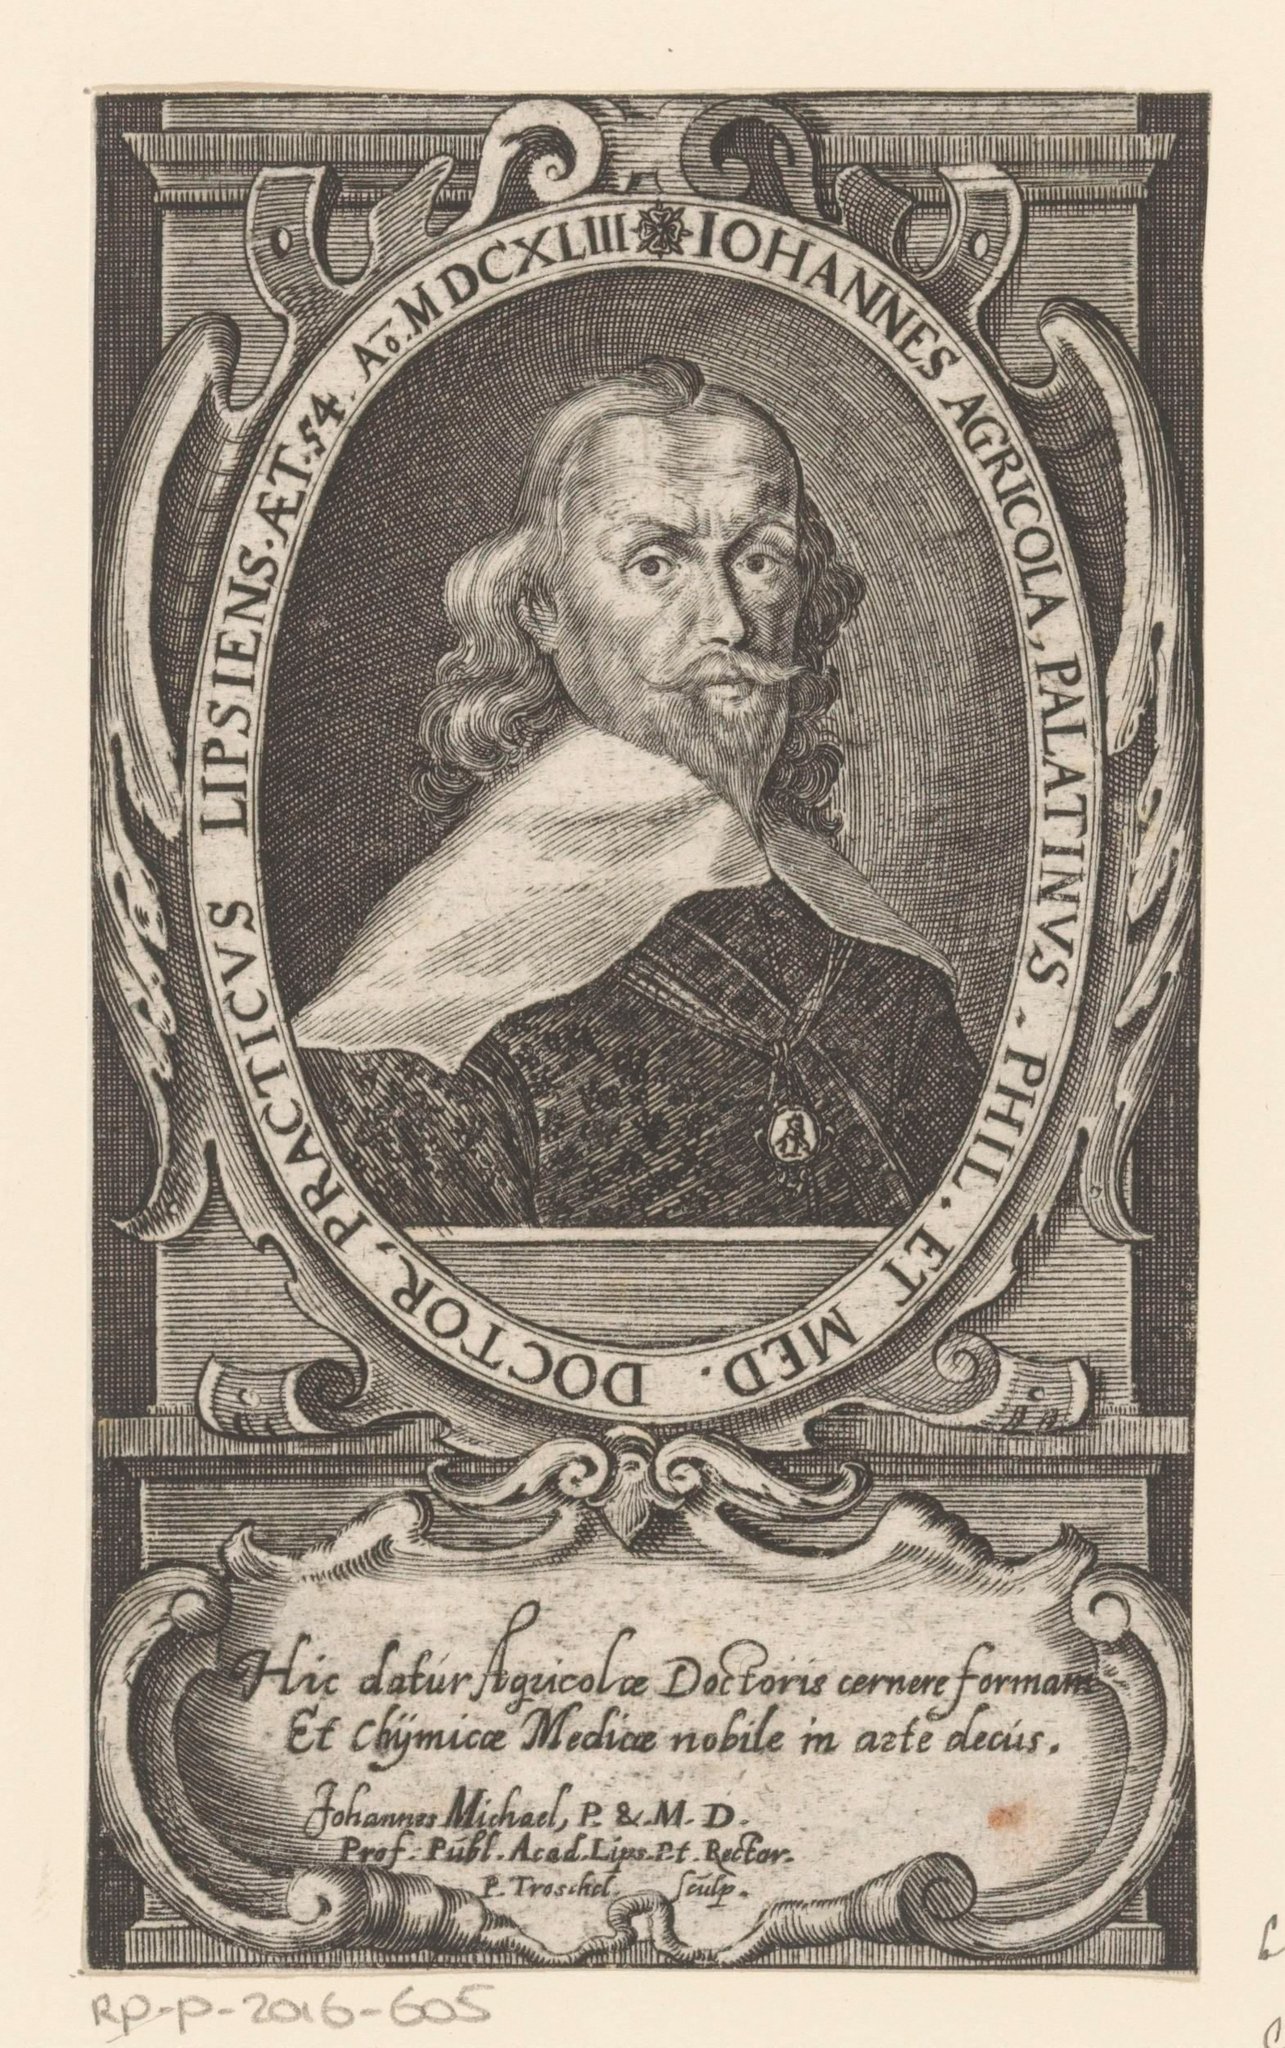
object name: print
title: Portret van Johannes Agricola II op 54-jarige leeftijd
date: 1643-1667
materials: paper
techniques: engraving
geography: nuremberg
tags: beieren, breslau, alchemist, arts, johann agricola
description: Portret van Johannes Agricola II in een geornamenteerde, ovale omlijsting met randschrift. In een cartouche twee regels Latijnse tekst.